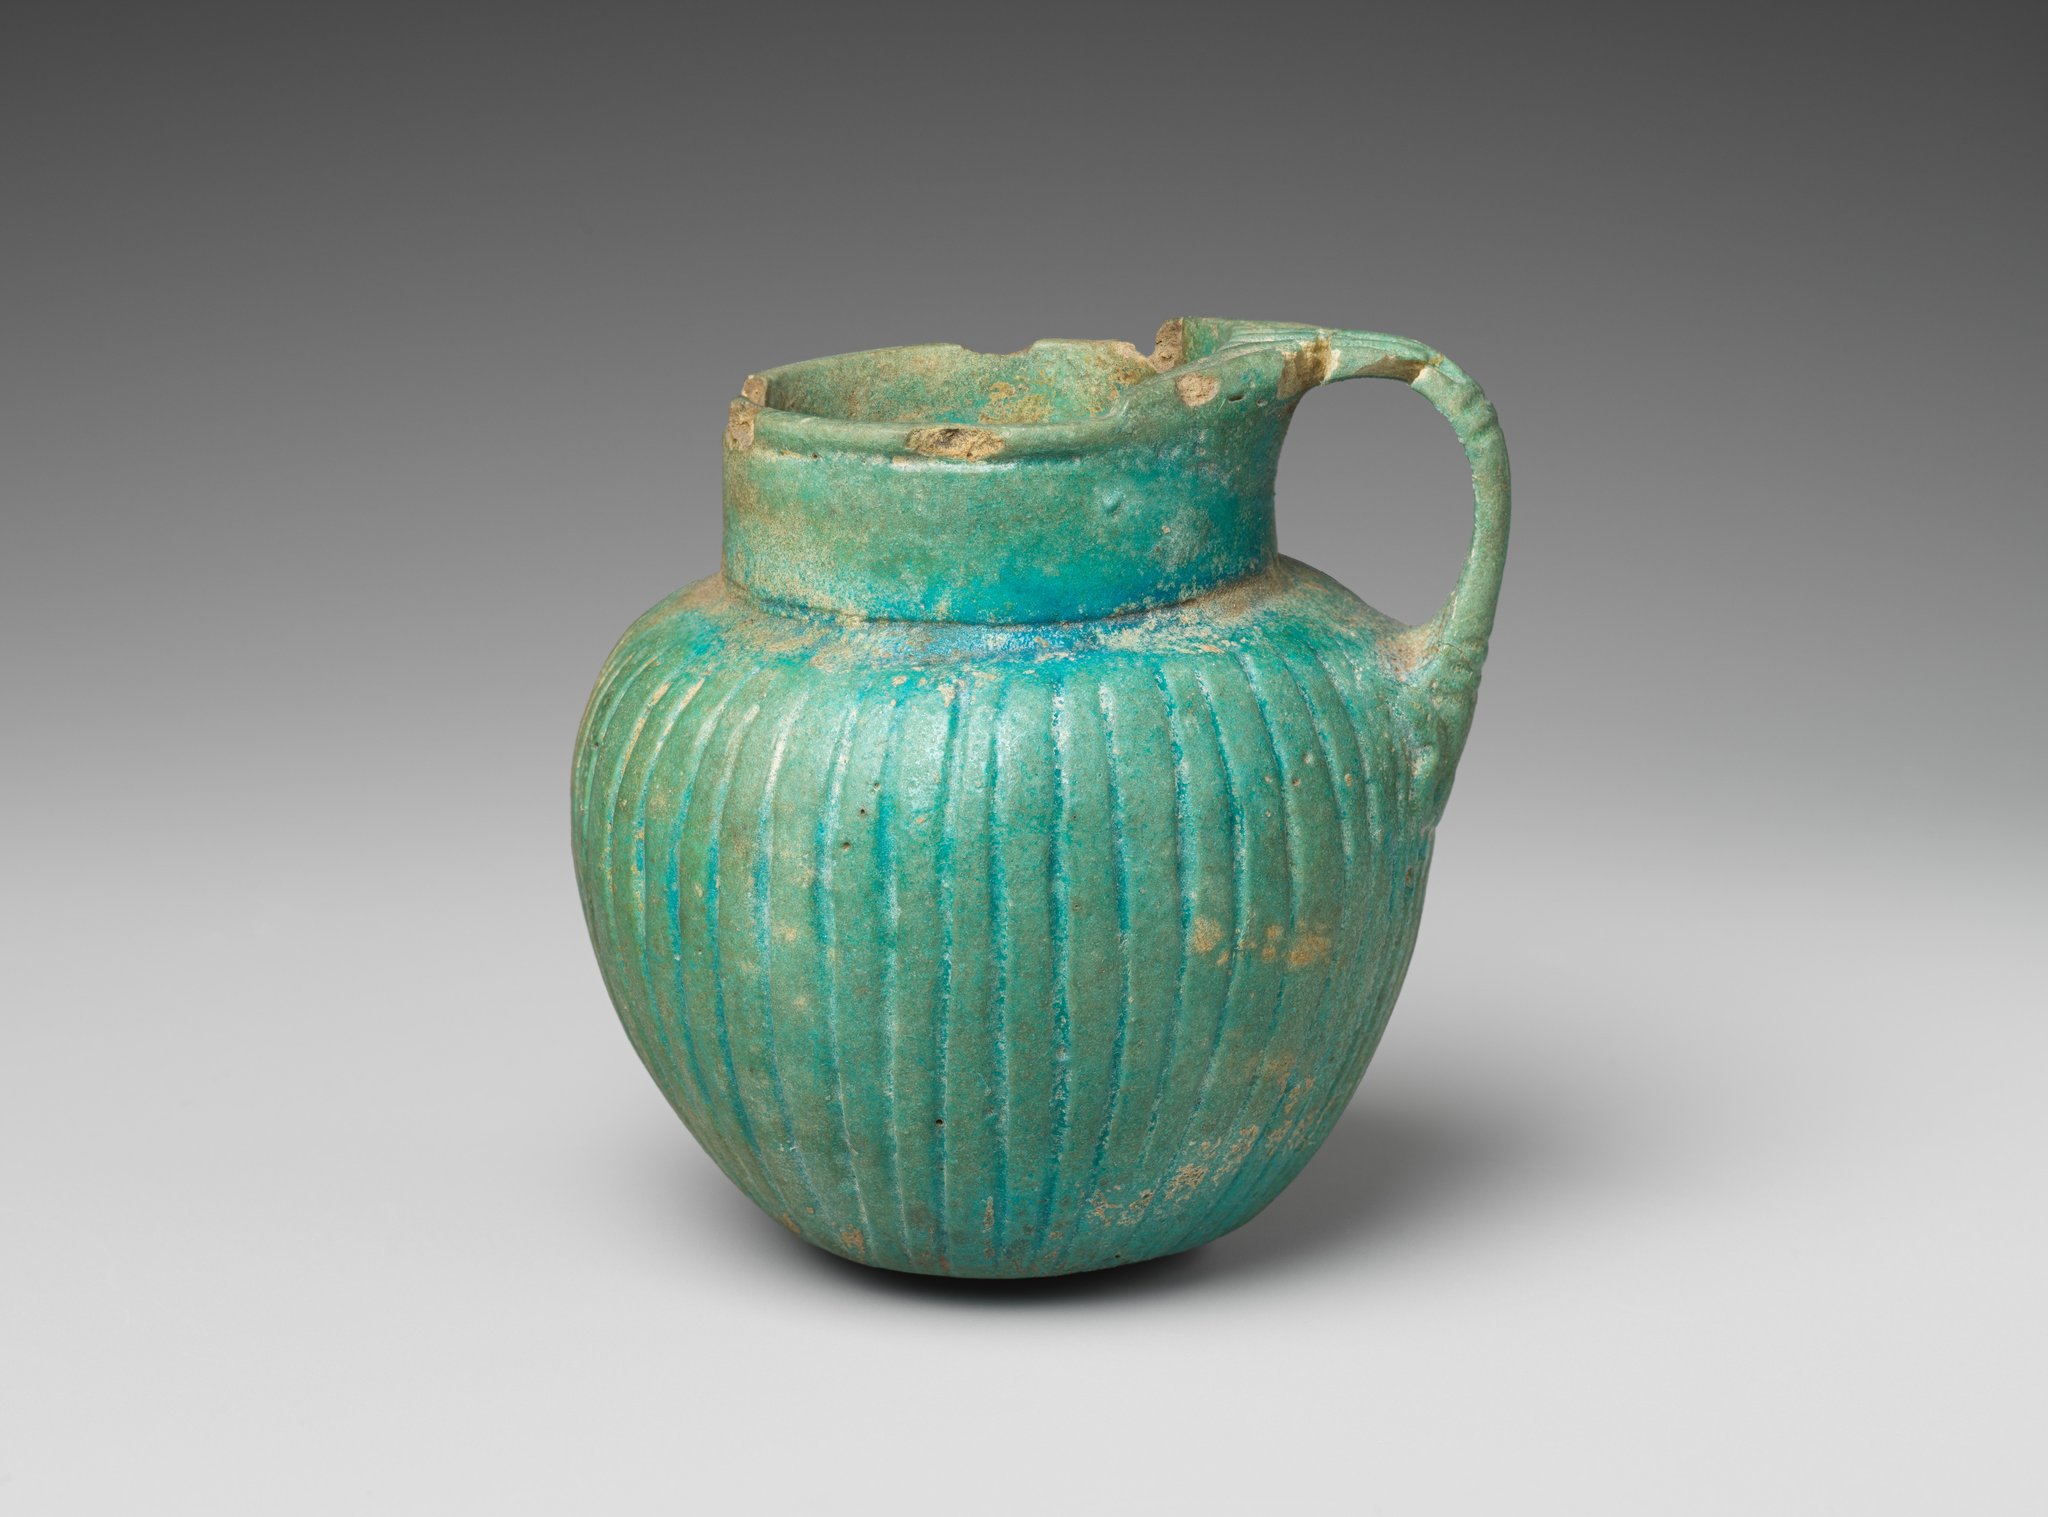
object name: jug, ribbed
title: Jug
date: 664-332 BCE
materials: faience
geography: egypt